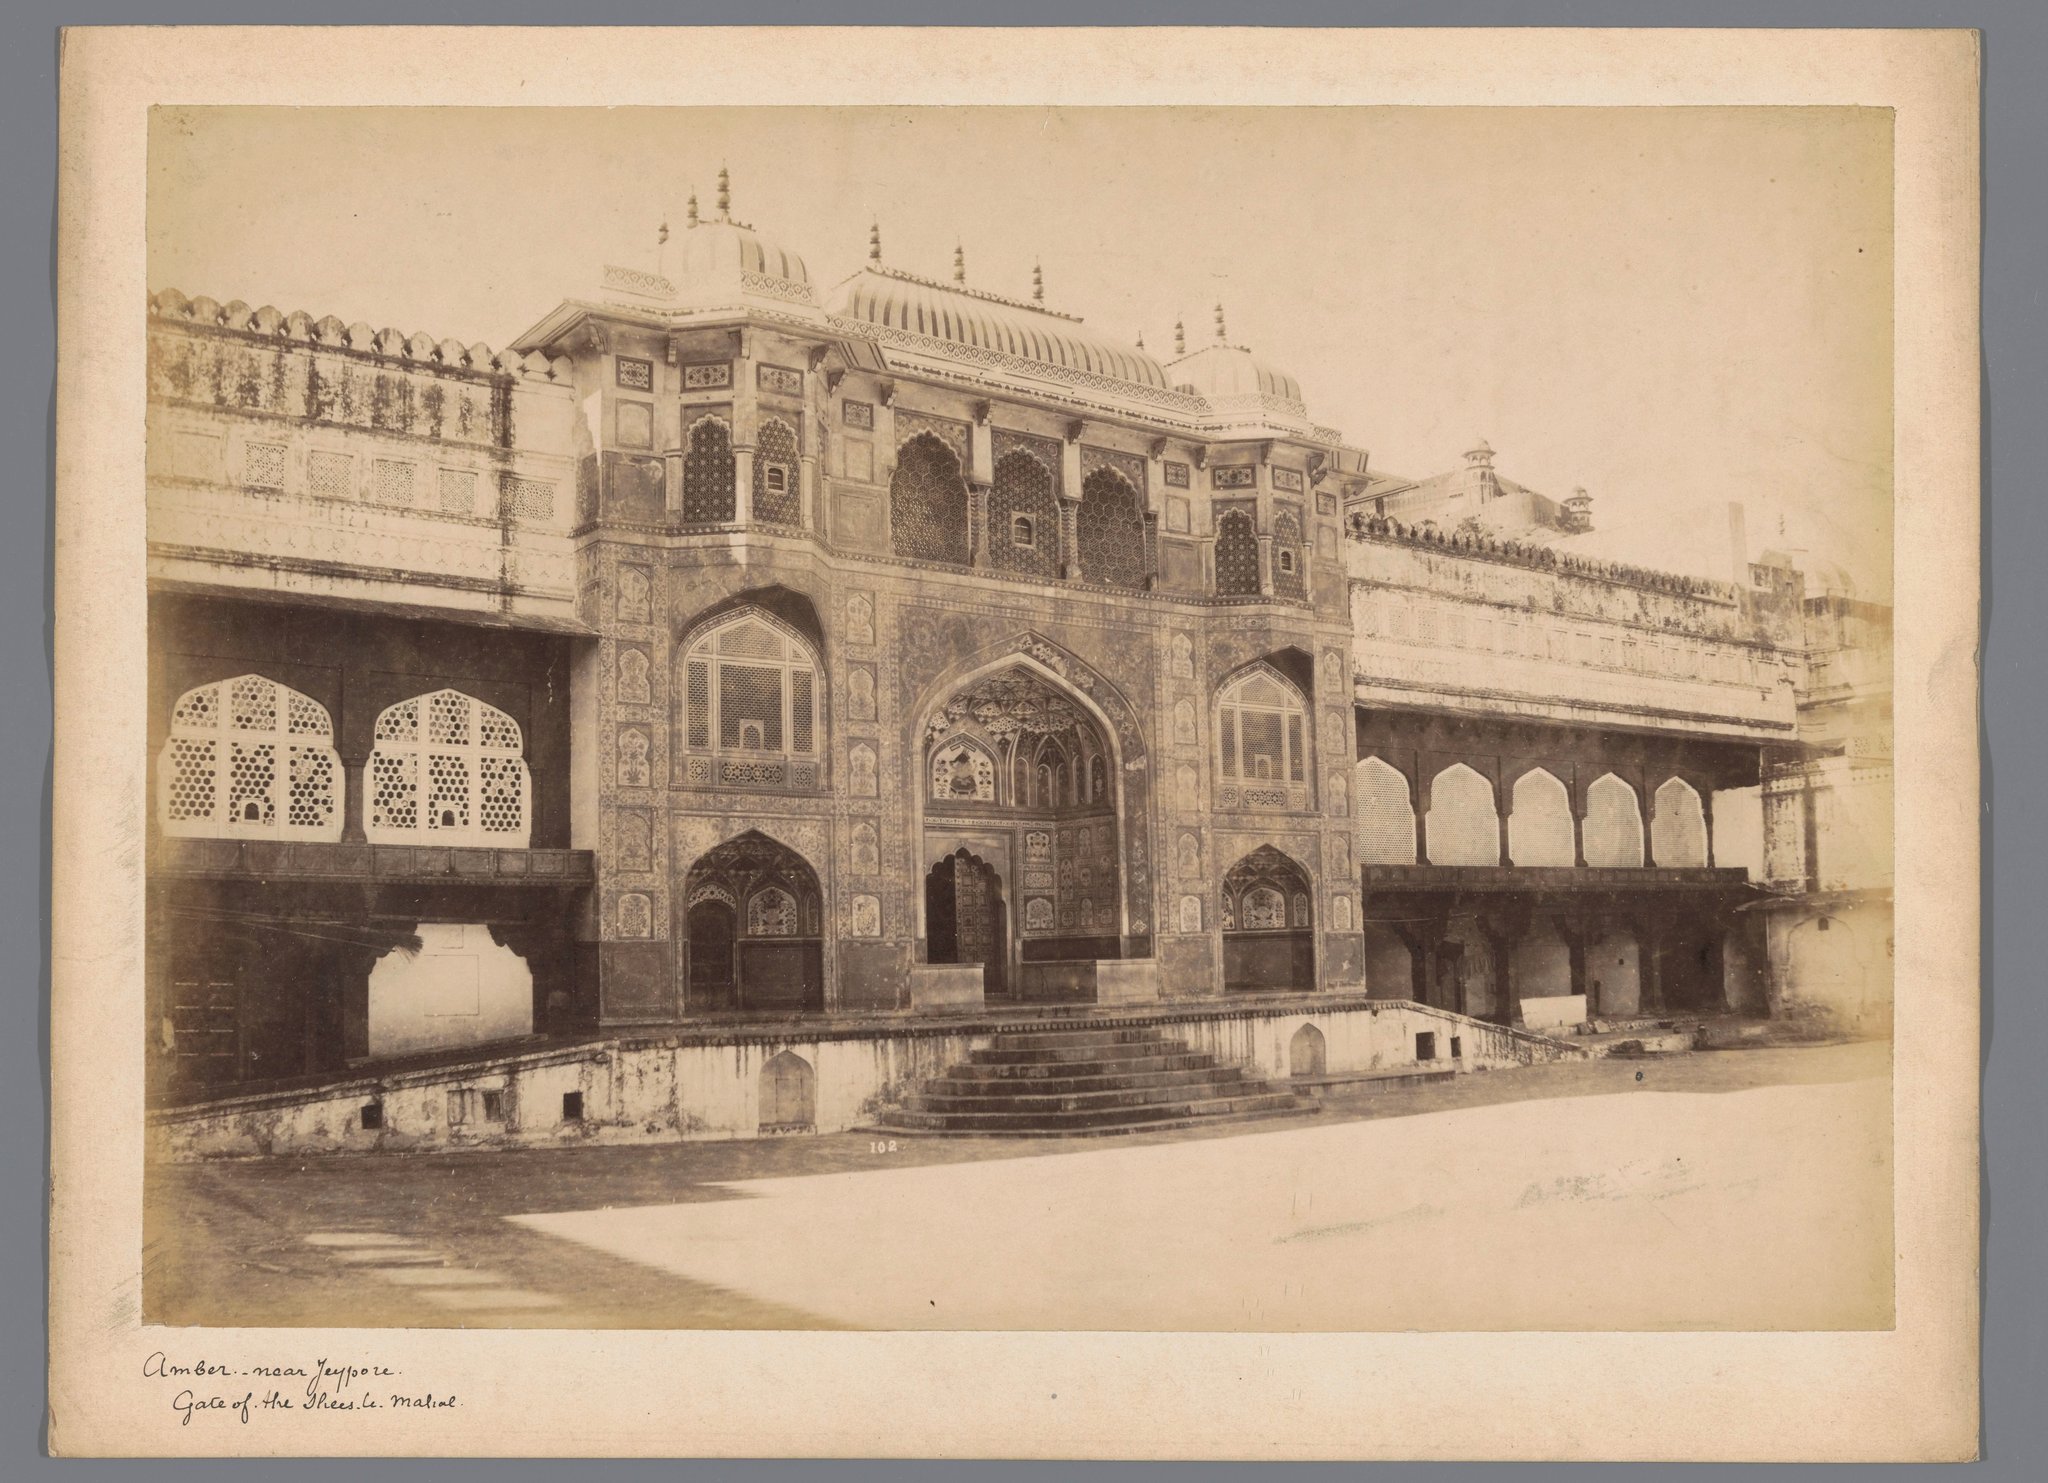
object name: photograph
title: Poort of the Sheesh Mahal in the Amer Fort near Jaipur, Rajasthan, India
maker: Anonymous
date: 1865-1890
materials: cardboard, paper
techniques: albumen print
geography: amer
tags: palace, gate, entrance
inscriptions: number: ‘84’, number: ‘102’, title: ‘Amber. - near Jeypore./ Gate of the Sheesh Mahal.’